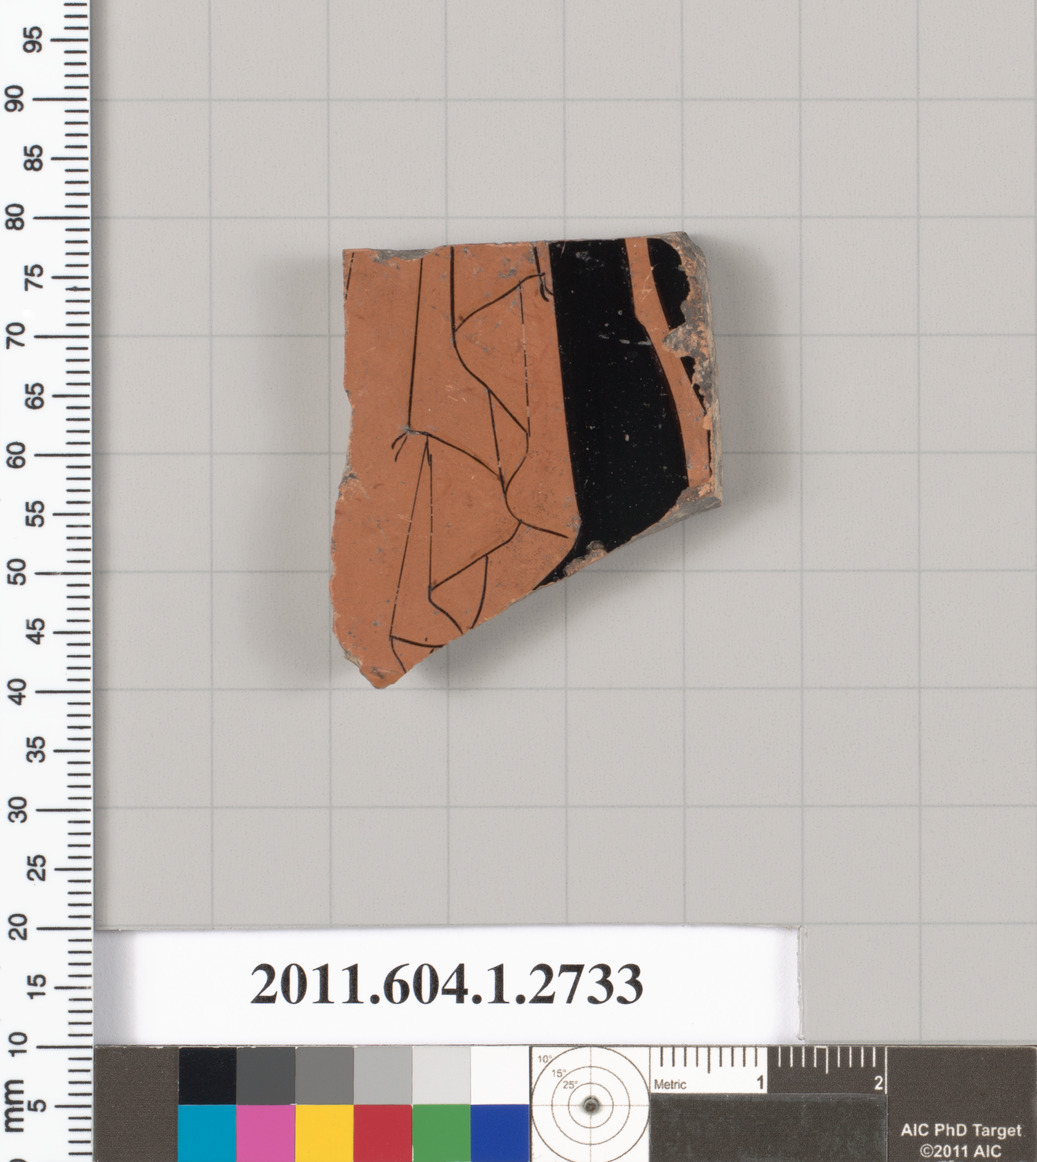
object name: kylix fragment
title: Terracotta fragment of a kylix (drinking cup)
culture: greek, attic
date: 475-451 BCE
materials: terracotta